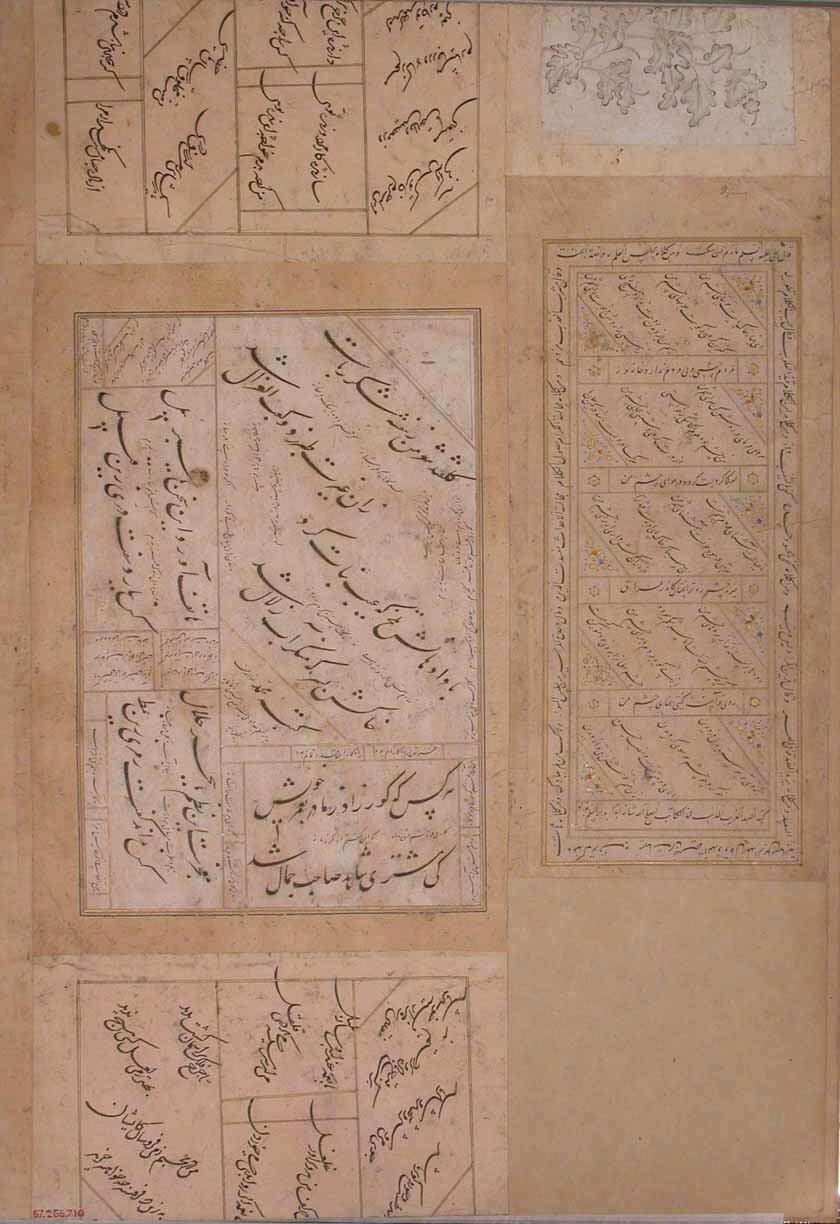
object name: album leaf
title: Page of Calligraphy from the Bellini Album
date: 1600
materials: gold, ink, paper, pencil, watercolor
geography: iran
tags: calligraphy